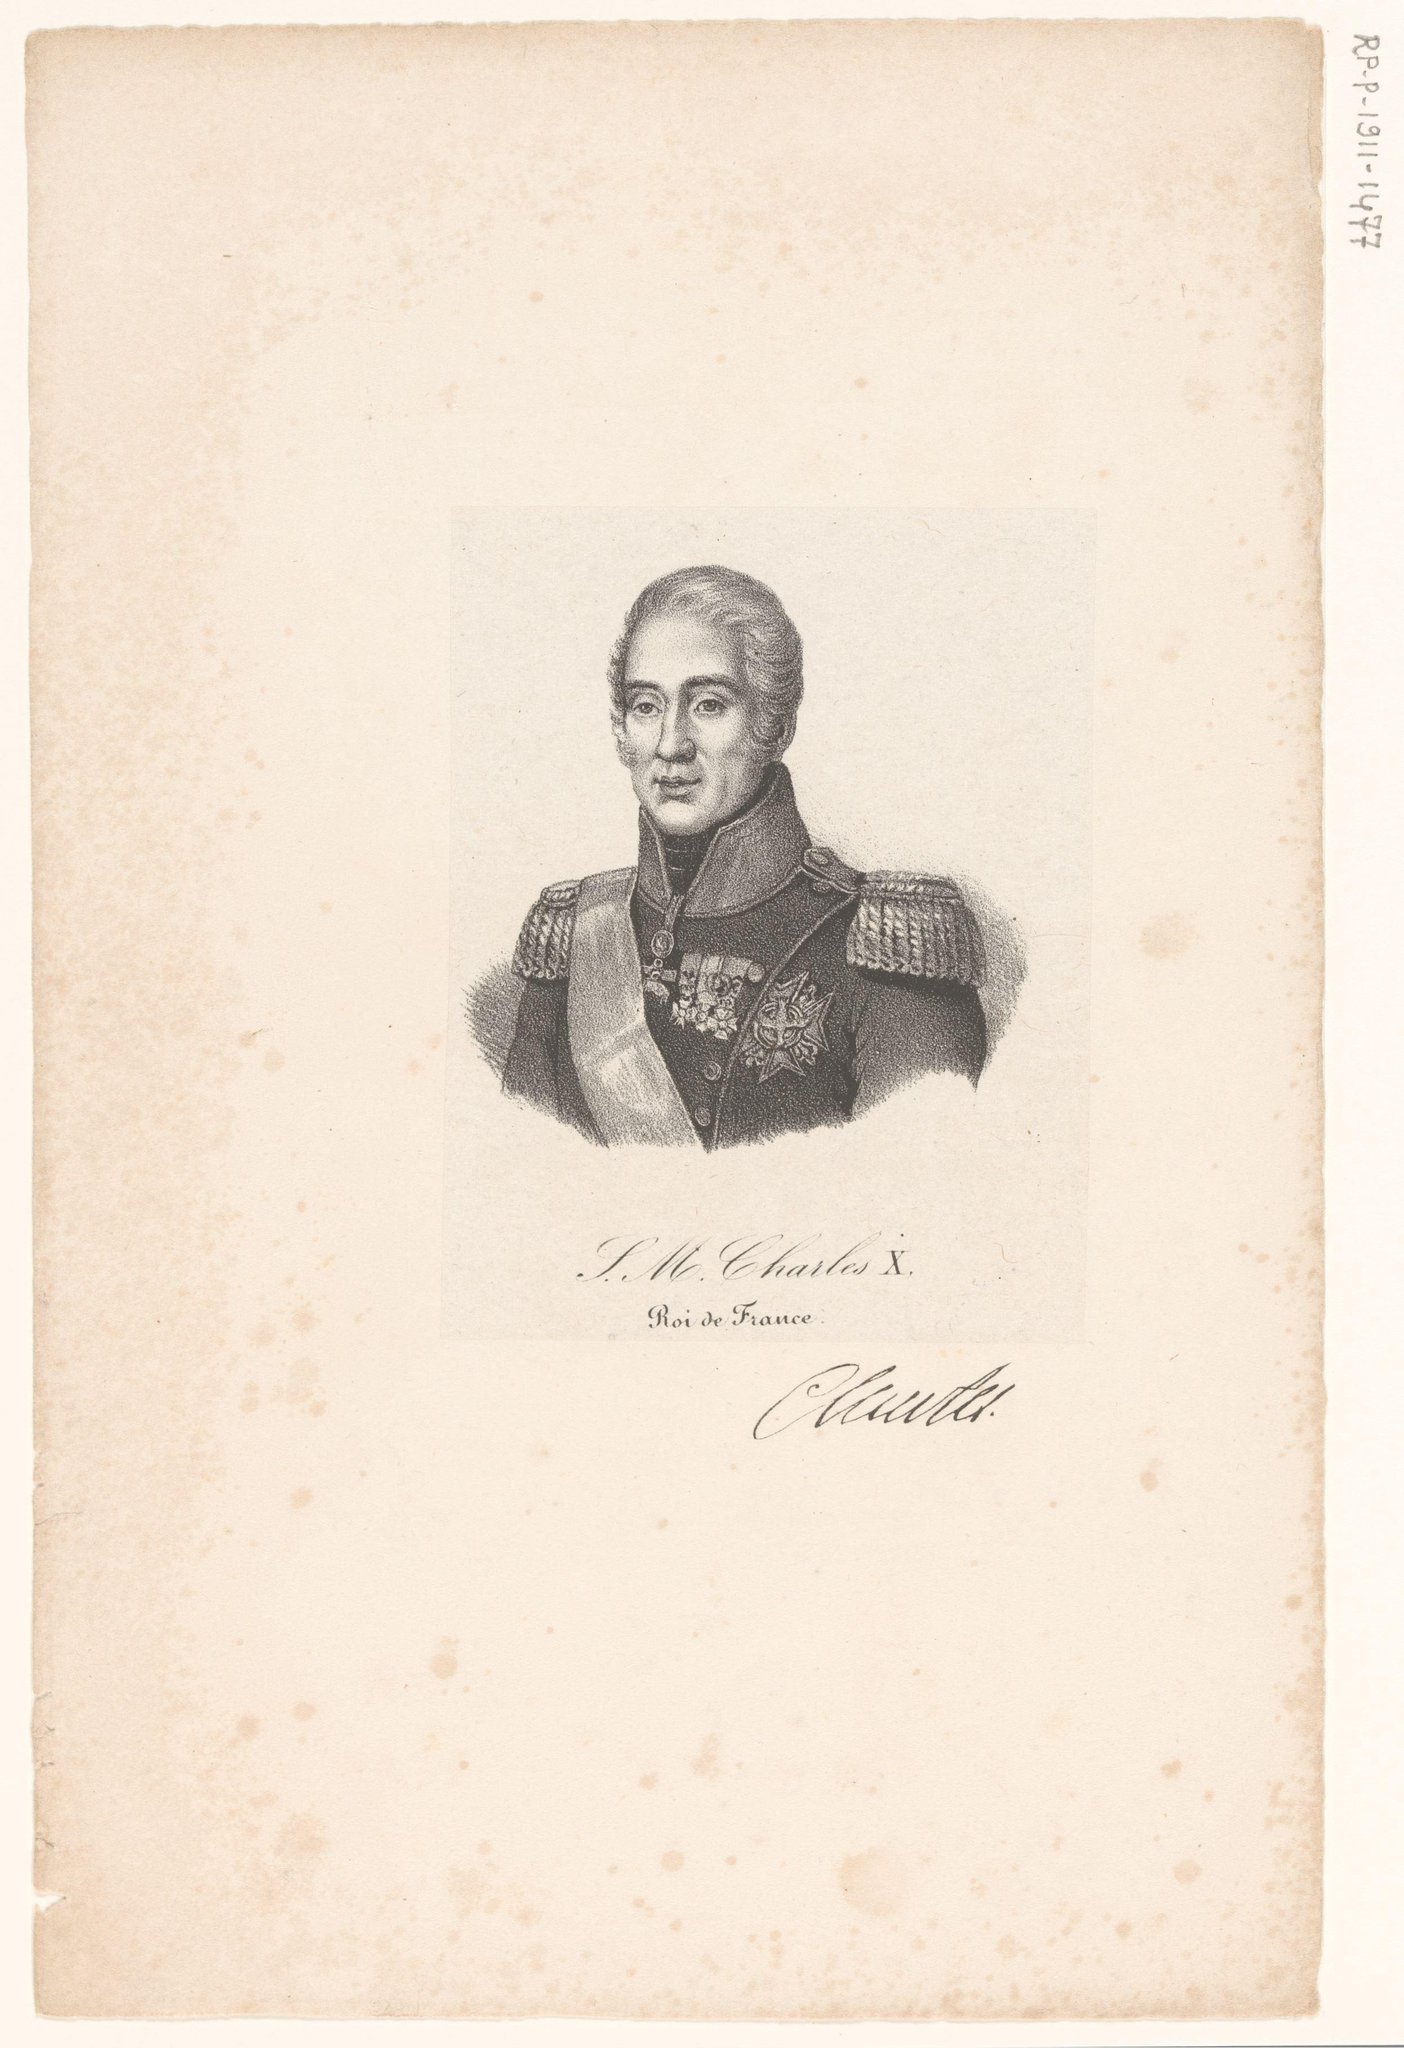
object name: print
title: Portret van Karel X van Frankrijk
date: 1818-1842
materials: paper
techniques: lithograph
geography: paris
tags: historical persons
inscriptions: collector's mark: Lugt 2228a